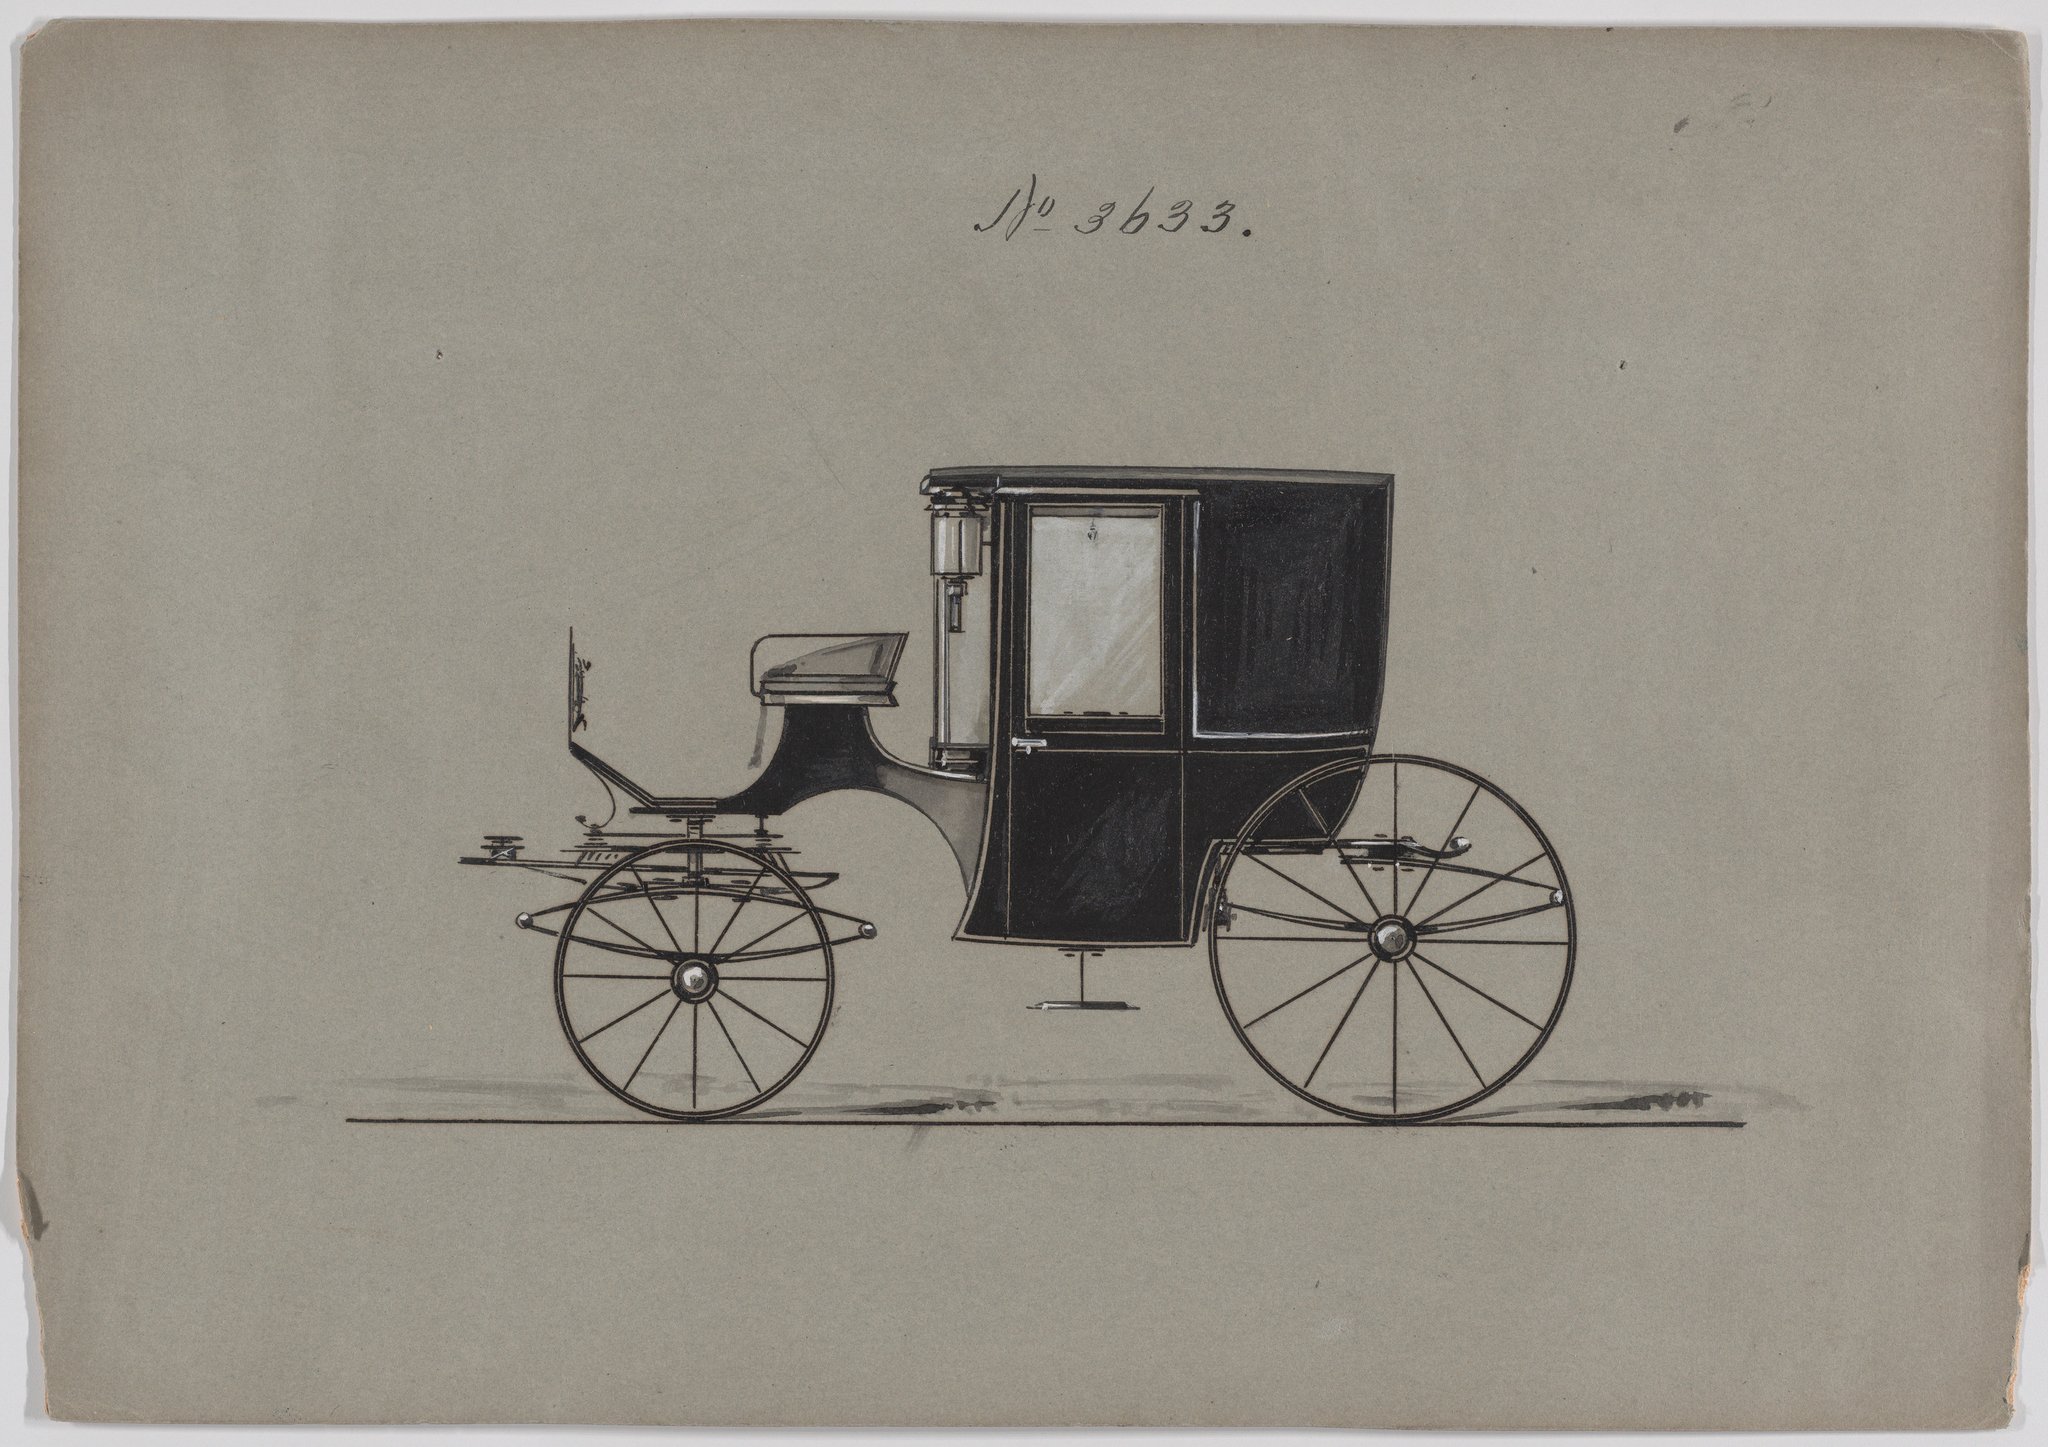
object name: drawing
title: Design for Coupé, no. 3633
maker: brewster & co.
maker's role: manufacturer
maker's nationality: american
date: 1880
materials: gouache, gum arabic, ink, watercolor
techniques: pen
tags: carriages